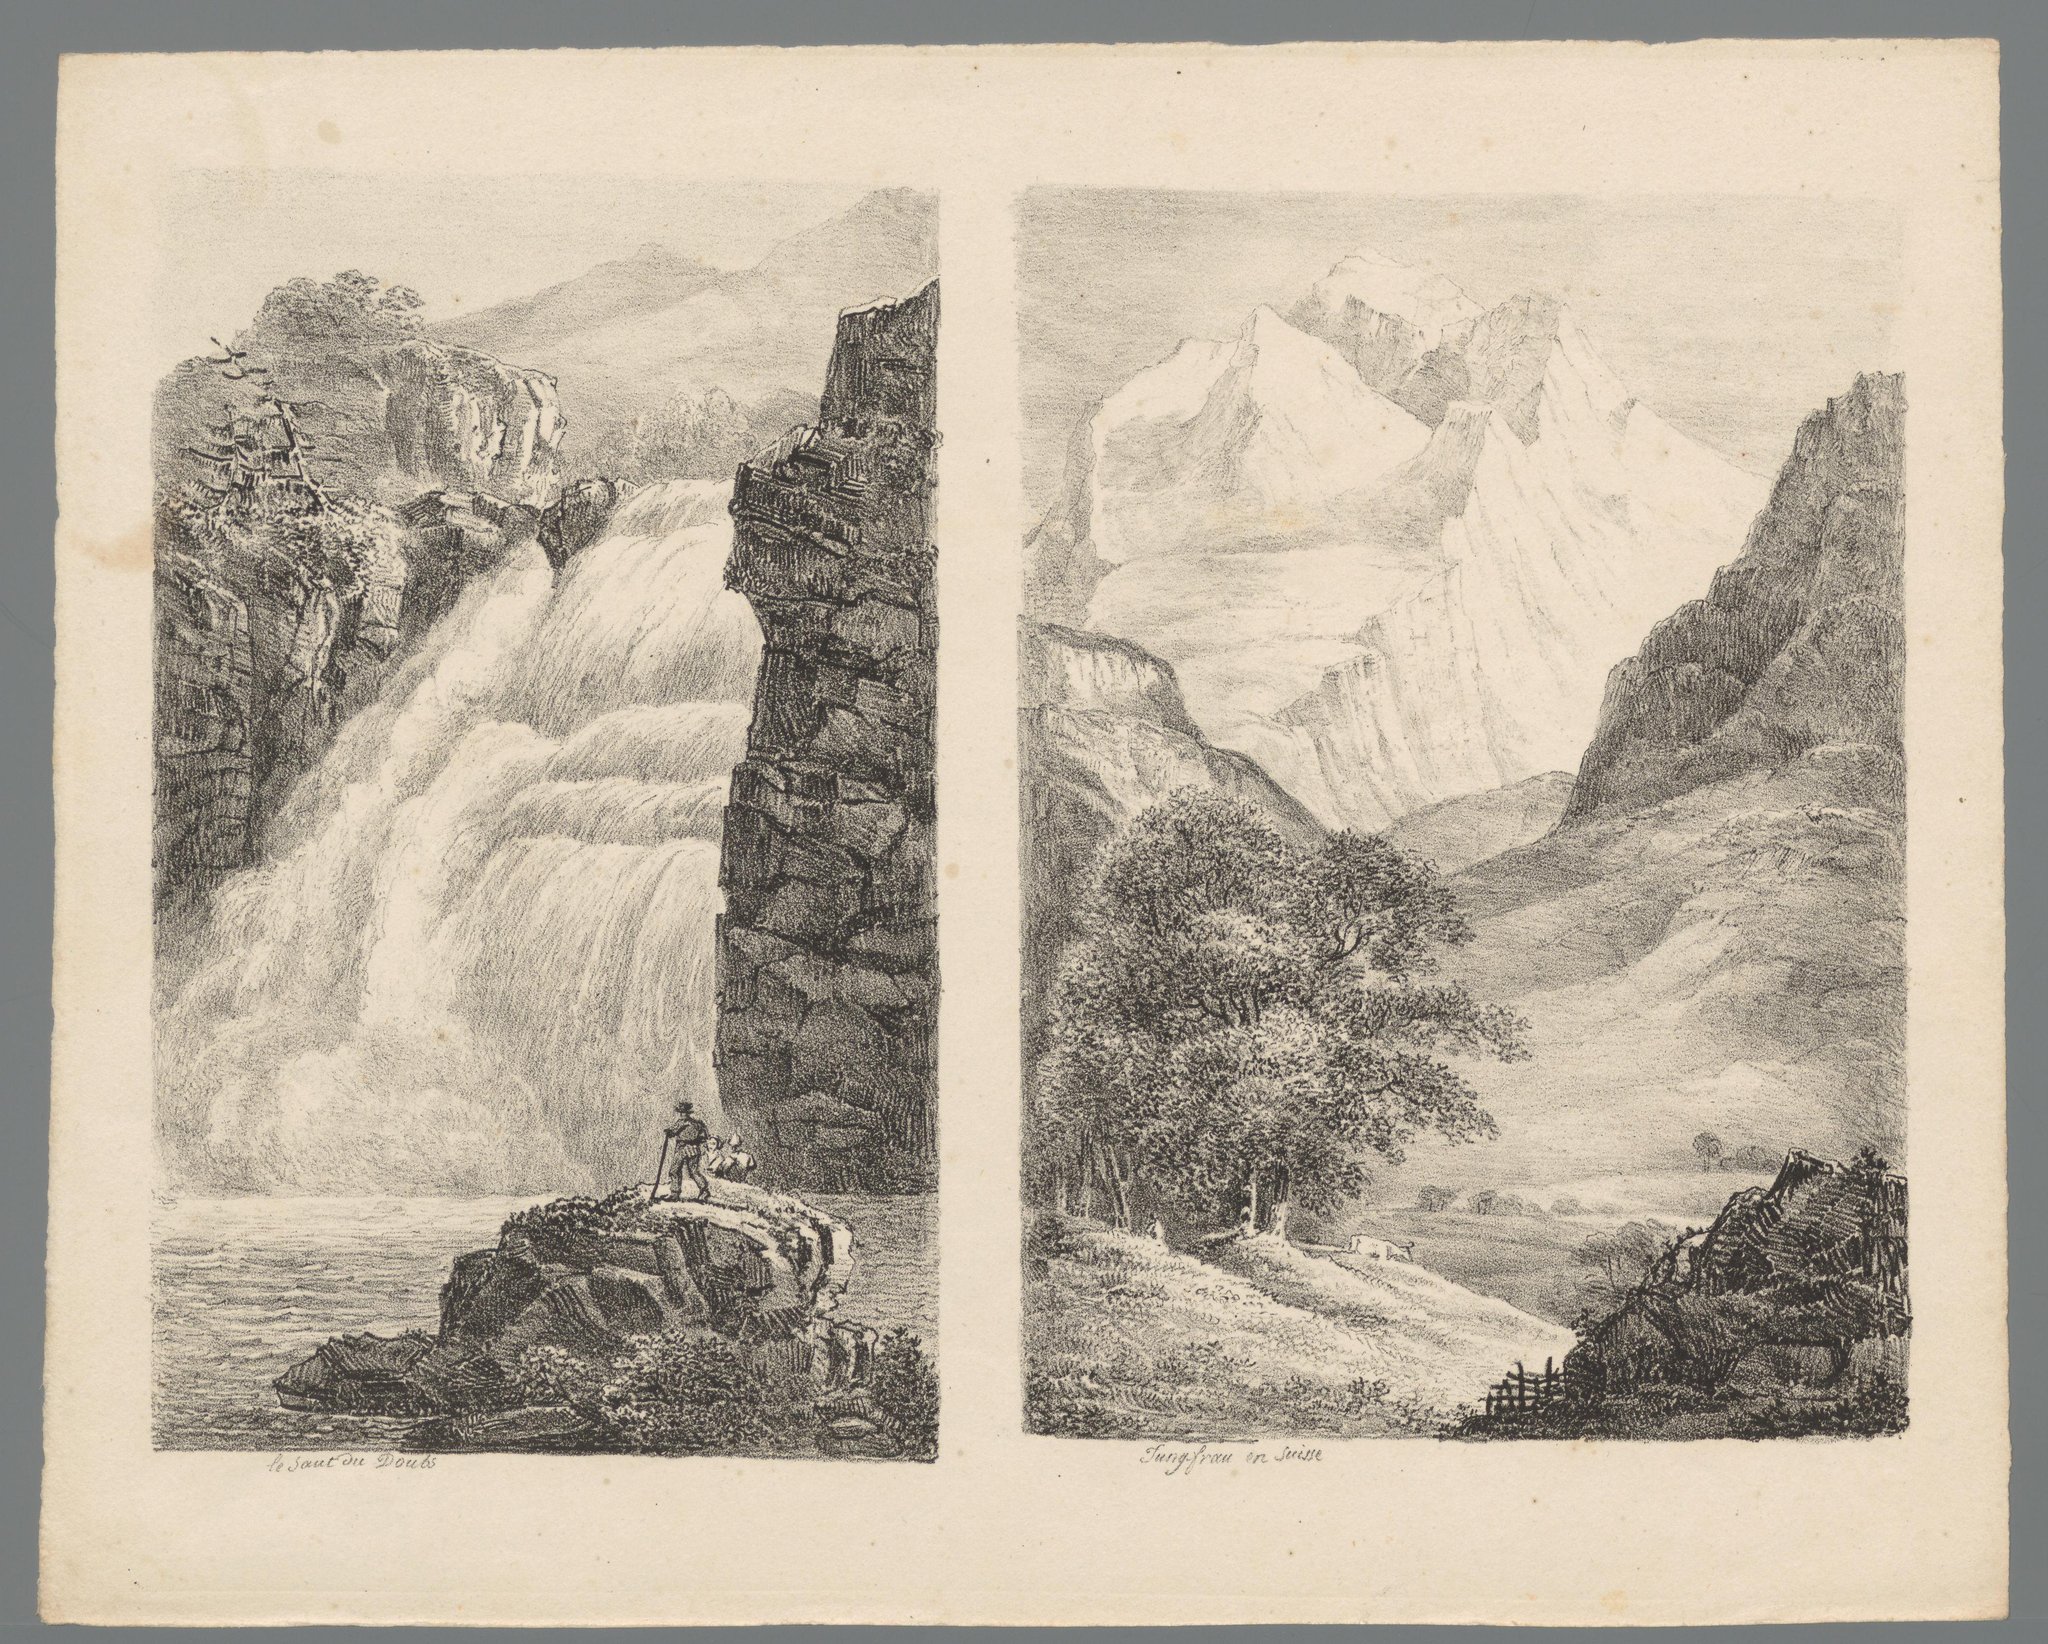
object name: print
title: Twee voorstellingen van een Zwitsers landschap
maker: richard sasse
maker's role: print maker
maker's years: 1774-1849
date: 1800-1849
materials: paper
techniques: lithograph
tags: waterfall, landscapes in the temperate zone (+ landscape with figures, staffage), mountains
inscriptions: collector's mark: Lugt 2228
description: Prent behoort tot de serie 'L'art de dessiner le paysage d'apres nature'. Deze serie is in tien delen met elk zes lithografieën uitgegeven.